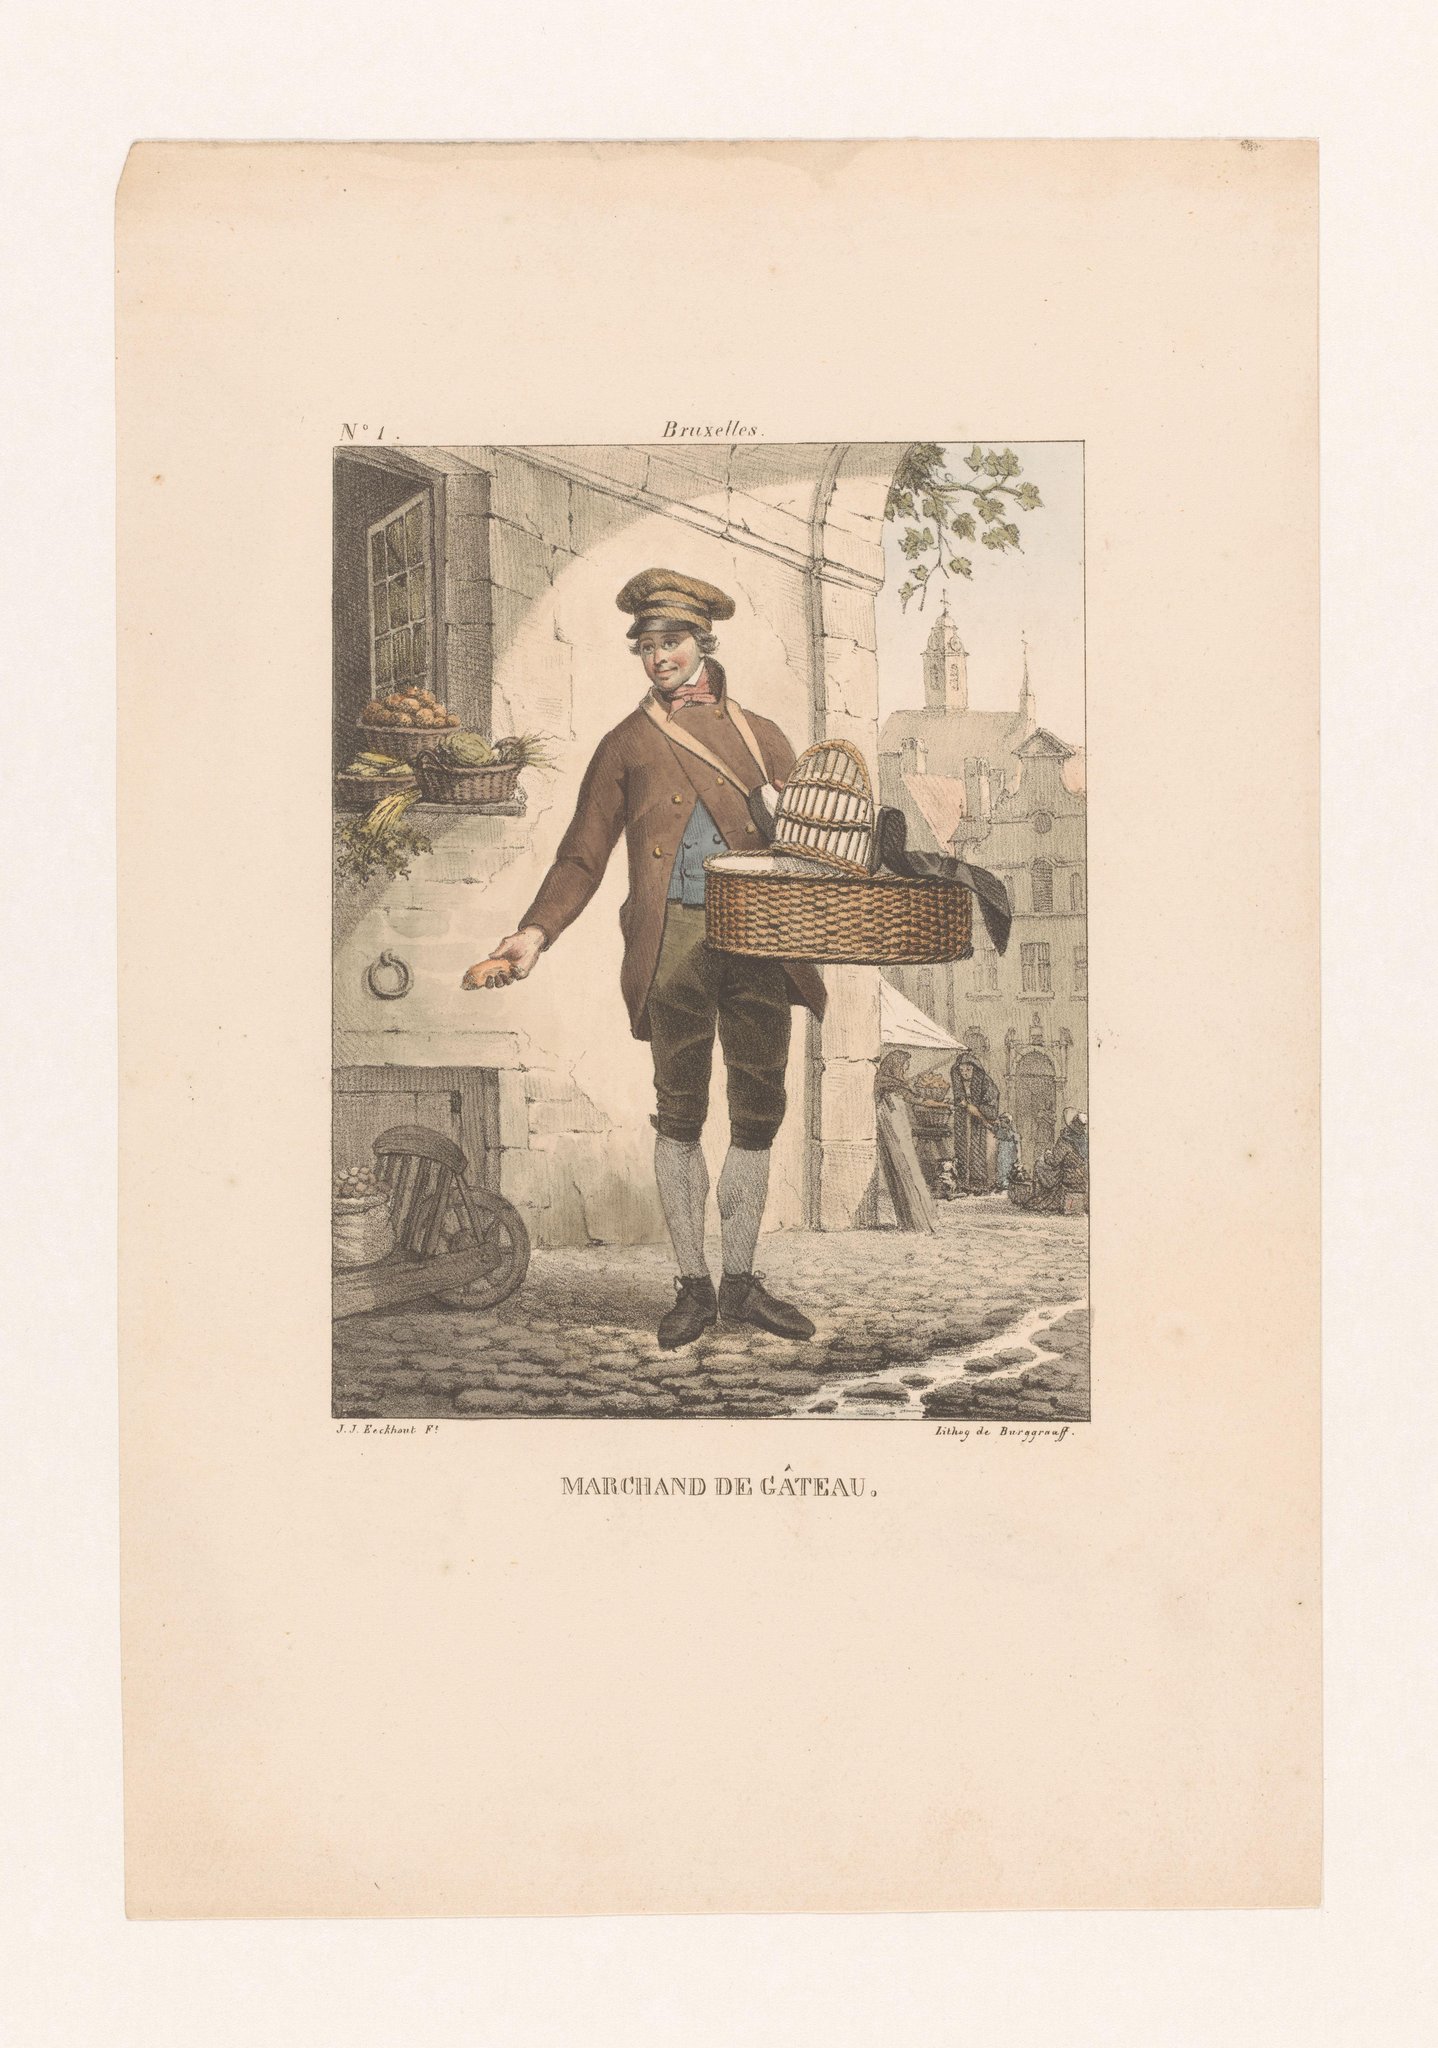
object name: print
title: Verschillende klederdrachten in het Verenigd Koninkrijk der Nederlanden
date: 1825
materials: paper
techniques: hand coloring, lithograph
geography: brussels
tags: street-trader, public road in village, bread, cake, pastry, etc., brussels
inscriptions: collector's mark: Lugt 2228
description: Prent maakt deel uit van een serie van 52 prenten.